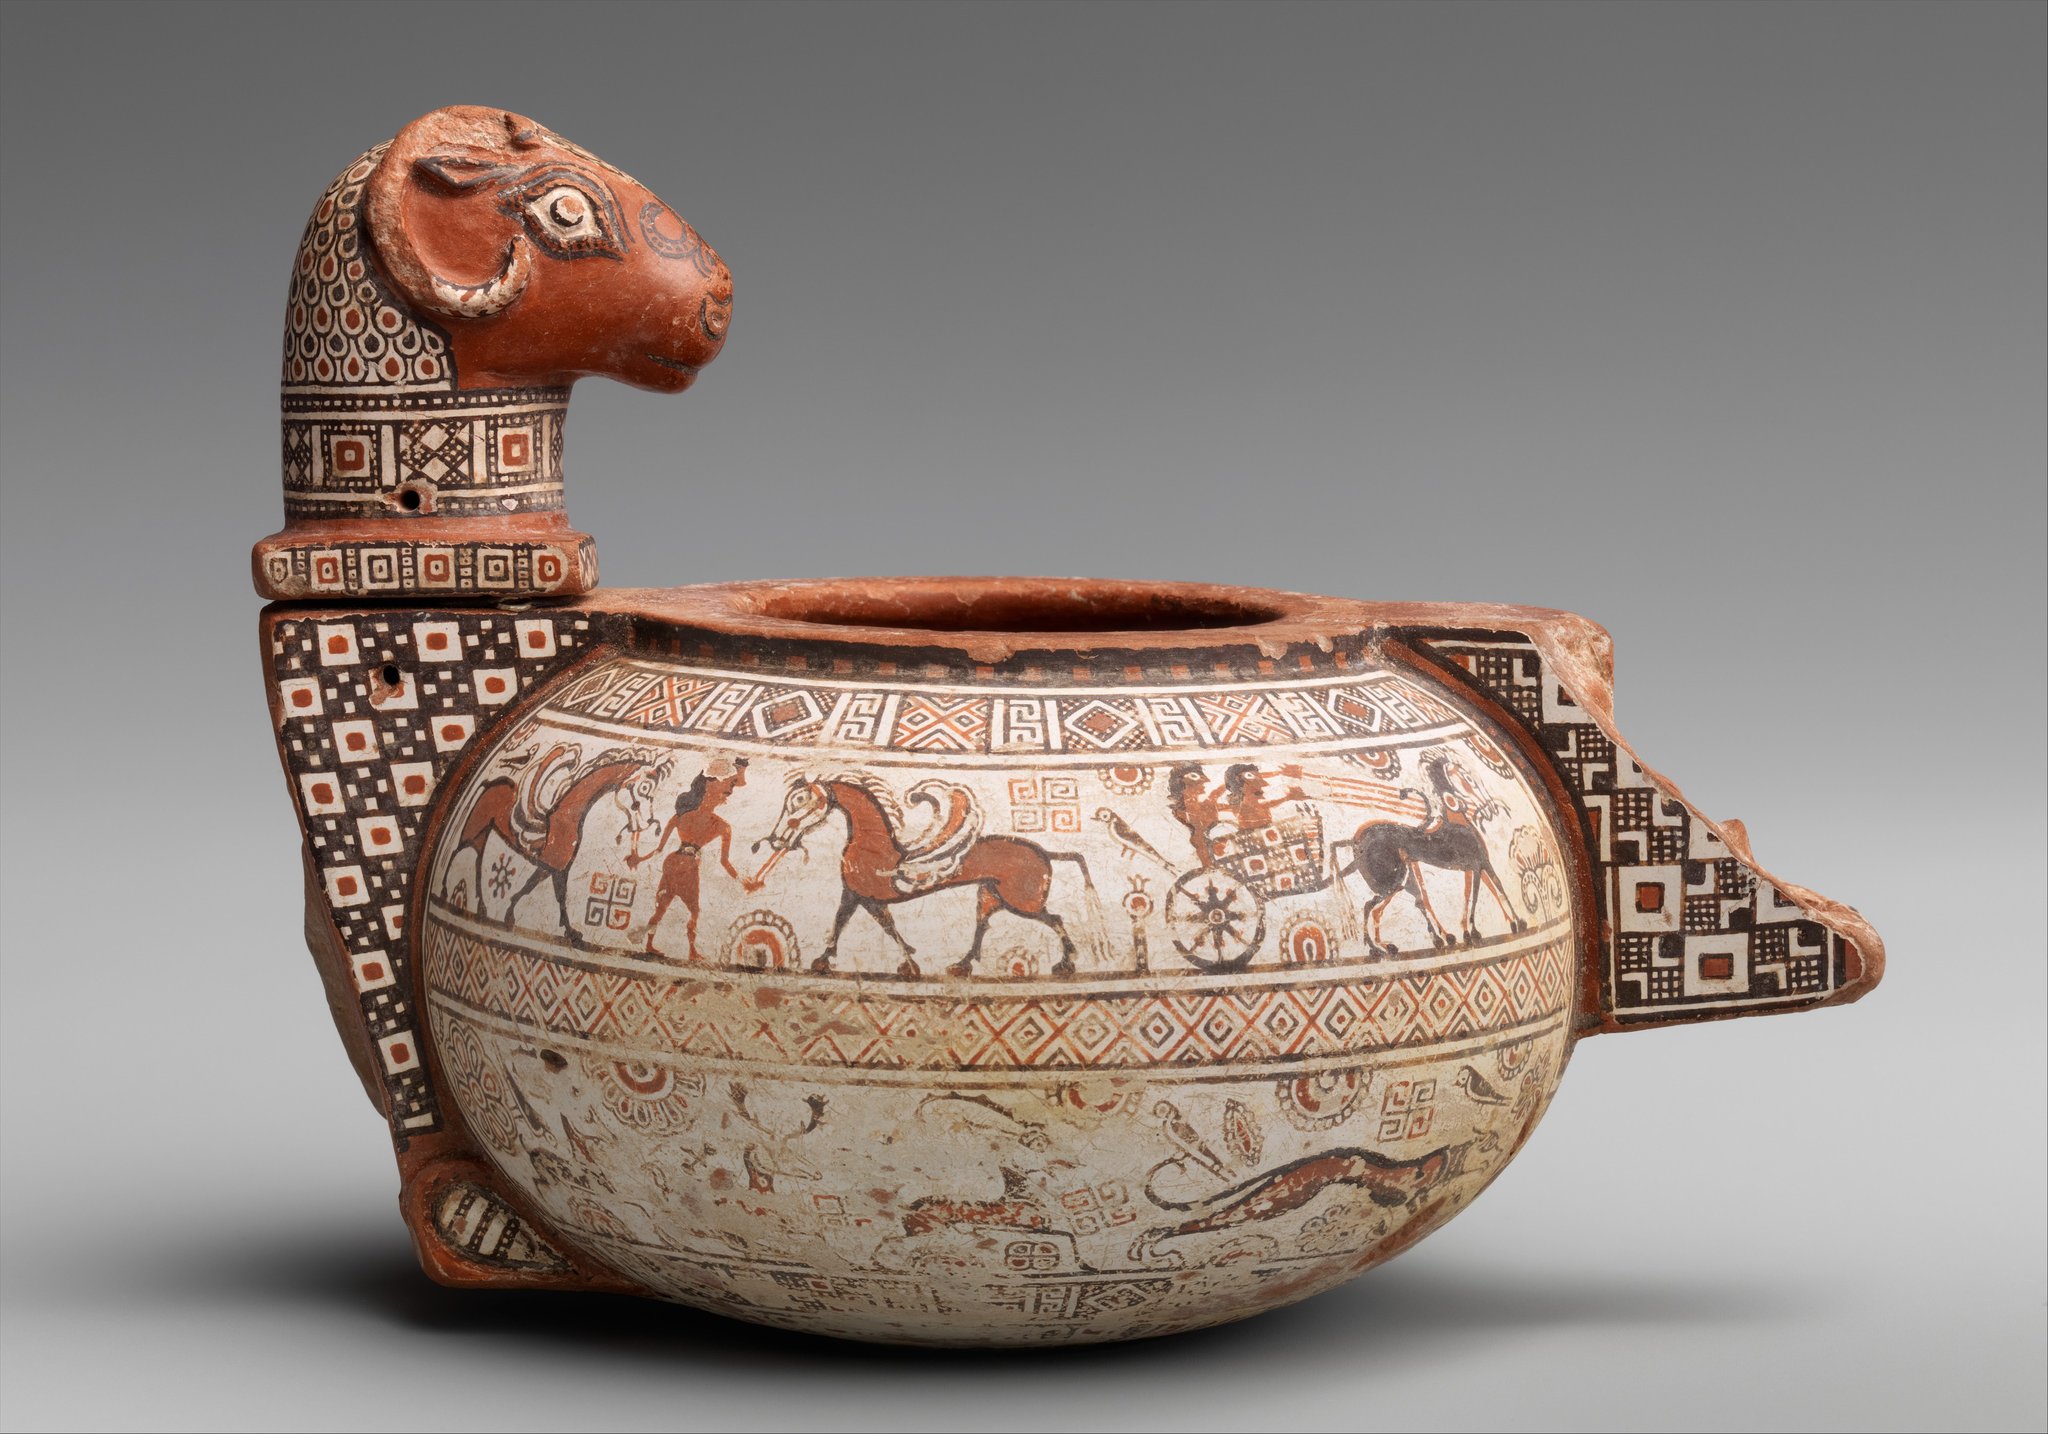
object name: vase with ram's head protome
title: Terracotta cosmetic vase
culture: east greek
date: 525-501 BCE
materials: terracotta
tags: birds,sphinx,horses,lions,rams,chariots